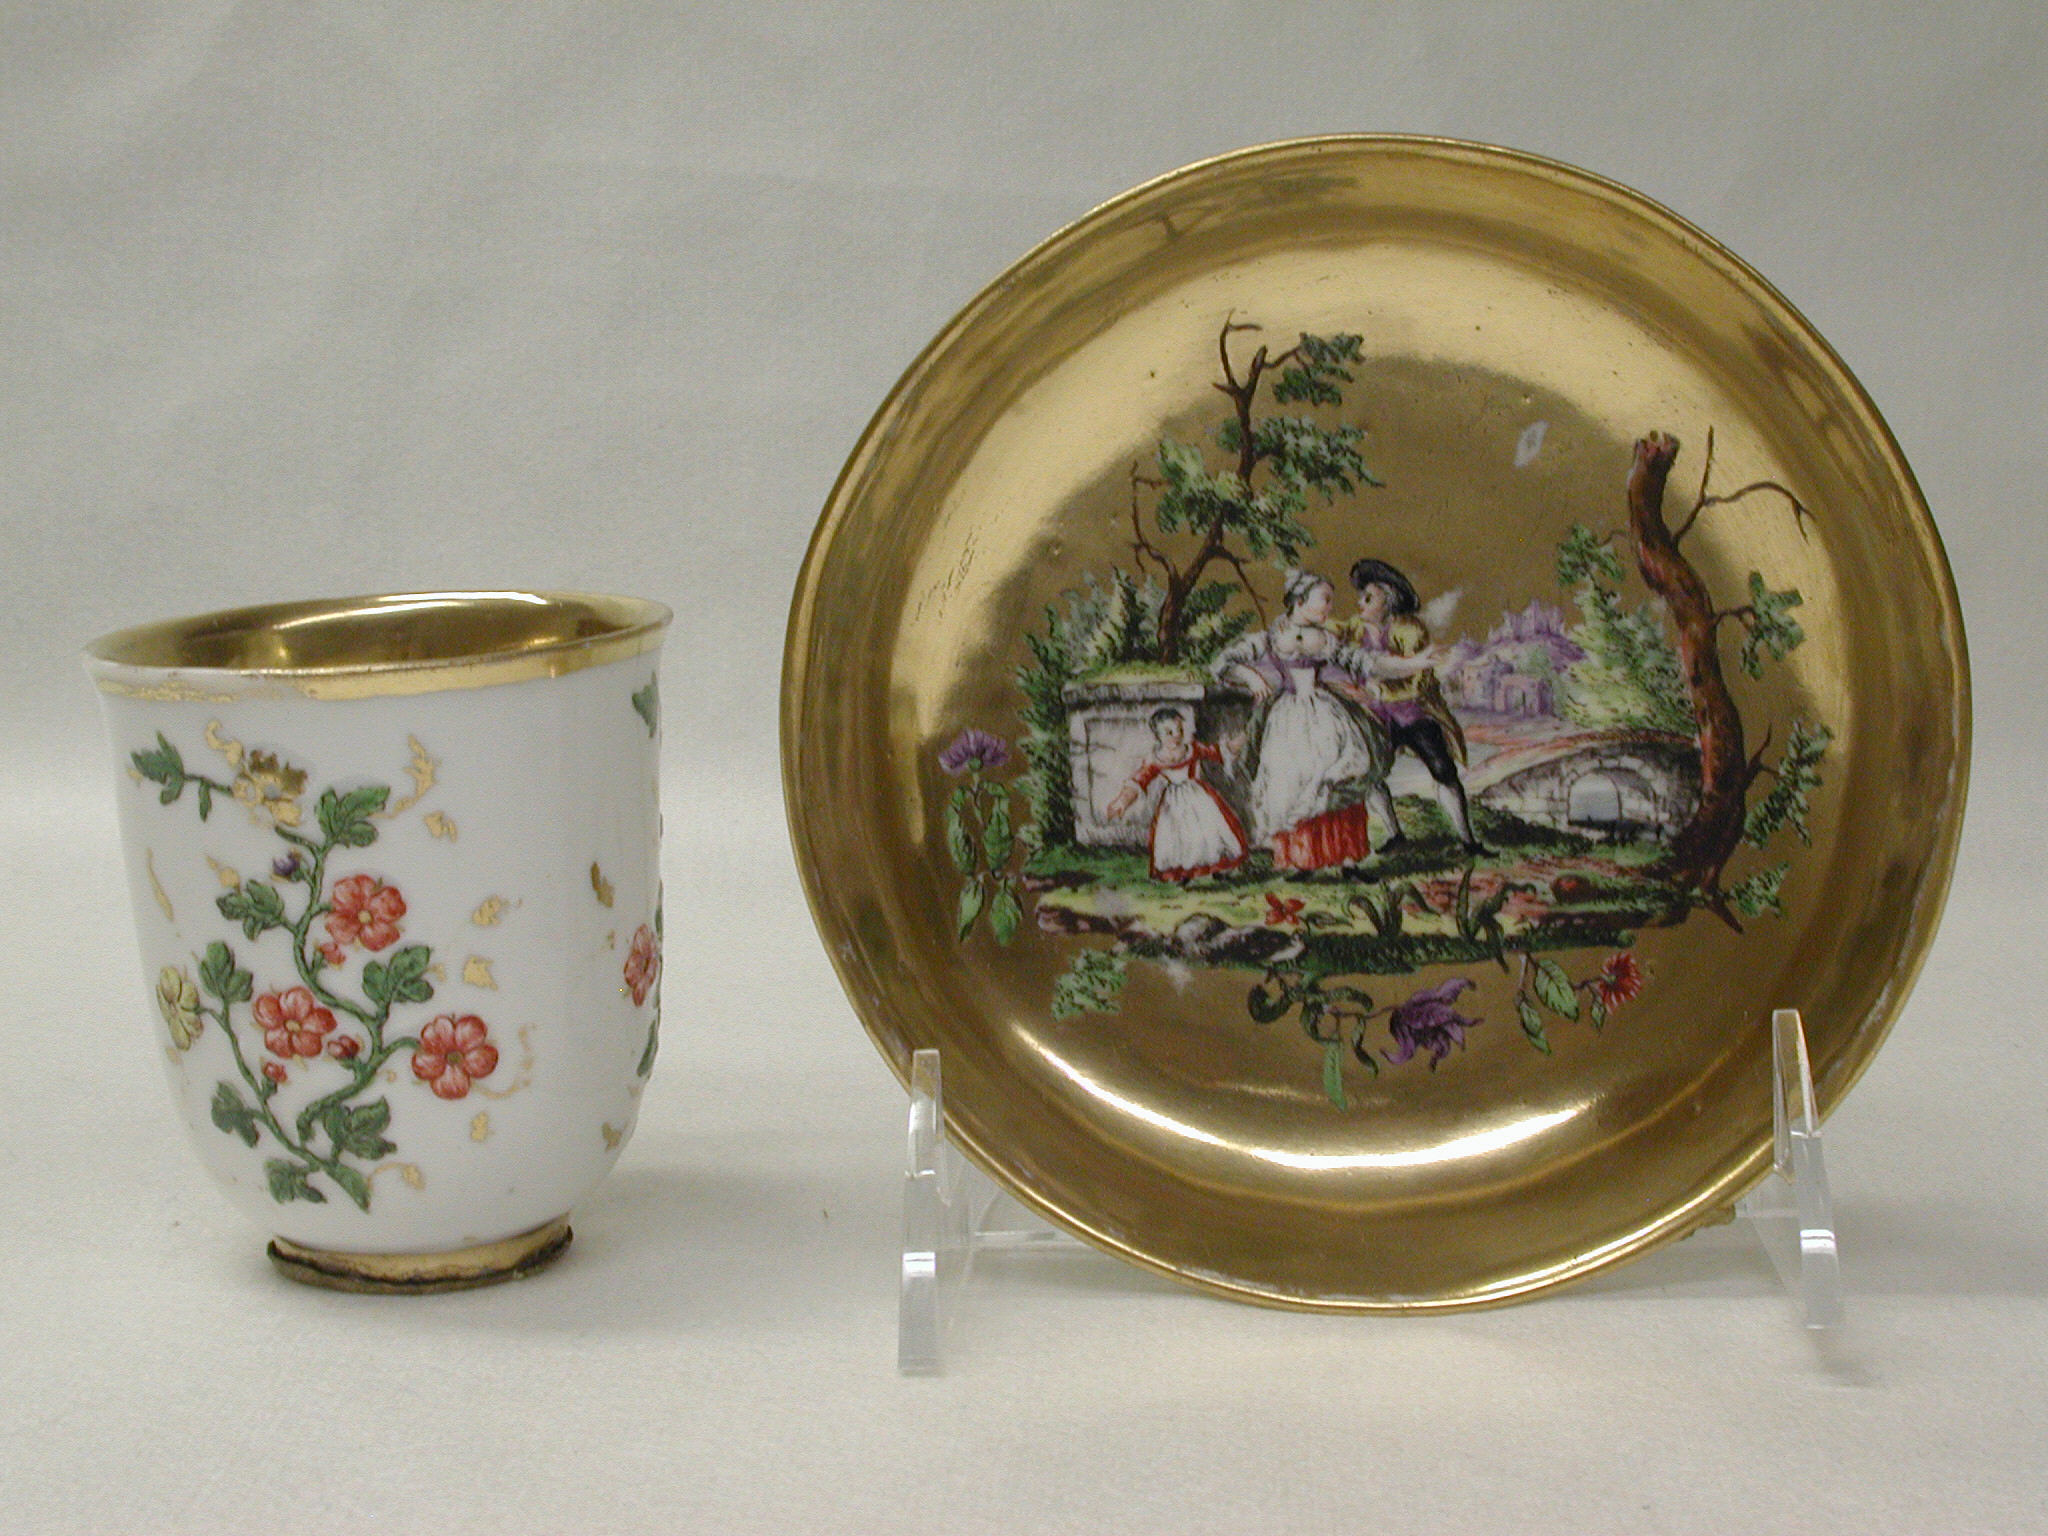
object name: coffee cup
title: Coffee cup (part of a service)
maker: nymphenburg porcelain manufactory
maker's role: manufactory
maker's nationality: german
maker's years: 1747-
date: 1760-1765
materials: hard paste porcelain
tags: flowers